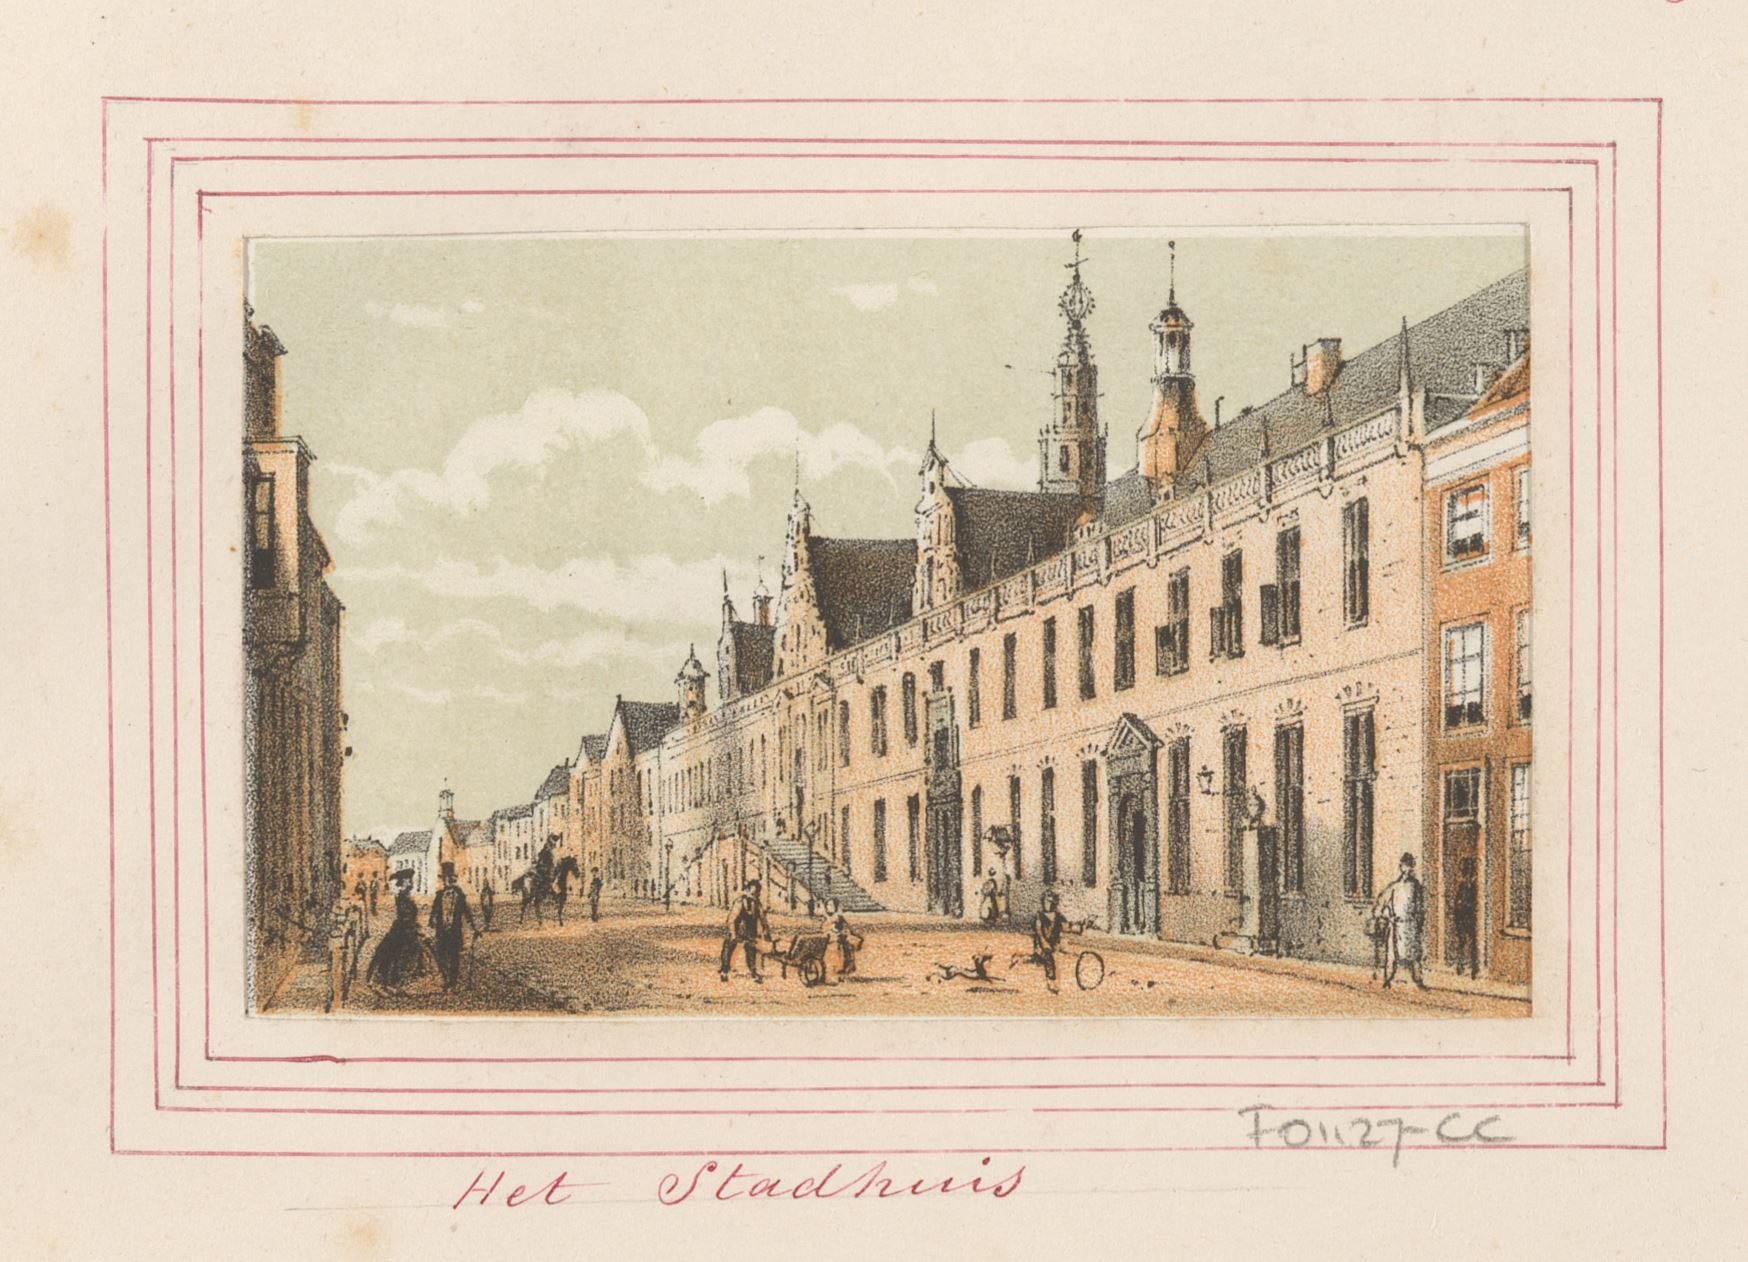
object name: print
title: Stadhuis van Leiden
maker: Anonymous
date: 1865-1875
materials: paper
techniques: tone lithography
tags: townhall, street (+ city(-scape) with figures, staffage)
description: Onderdeel van Album met foto's en litho's van bezienswaardigheden in Noord- en Zuid-Hollandse steden, schilderijen en klederdrachten.